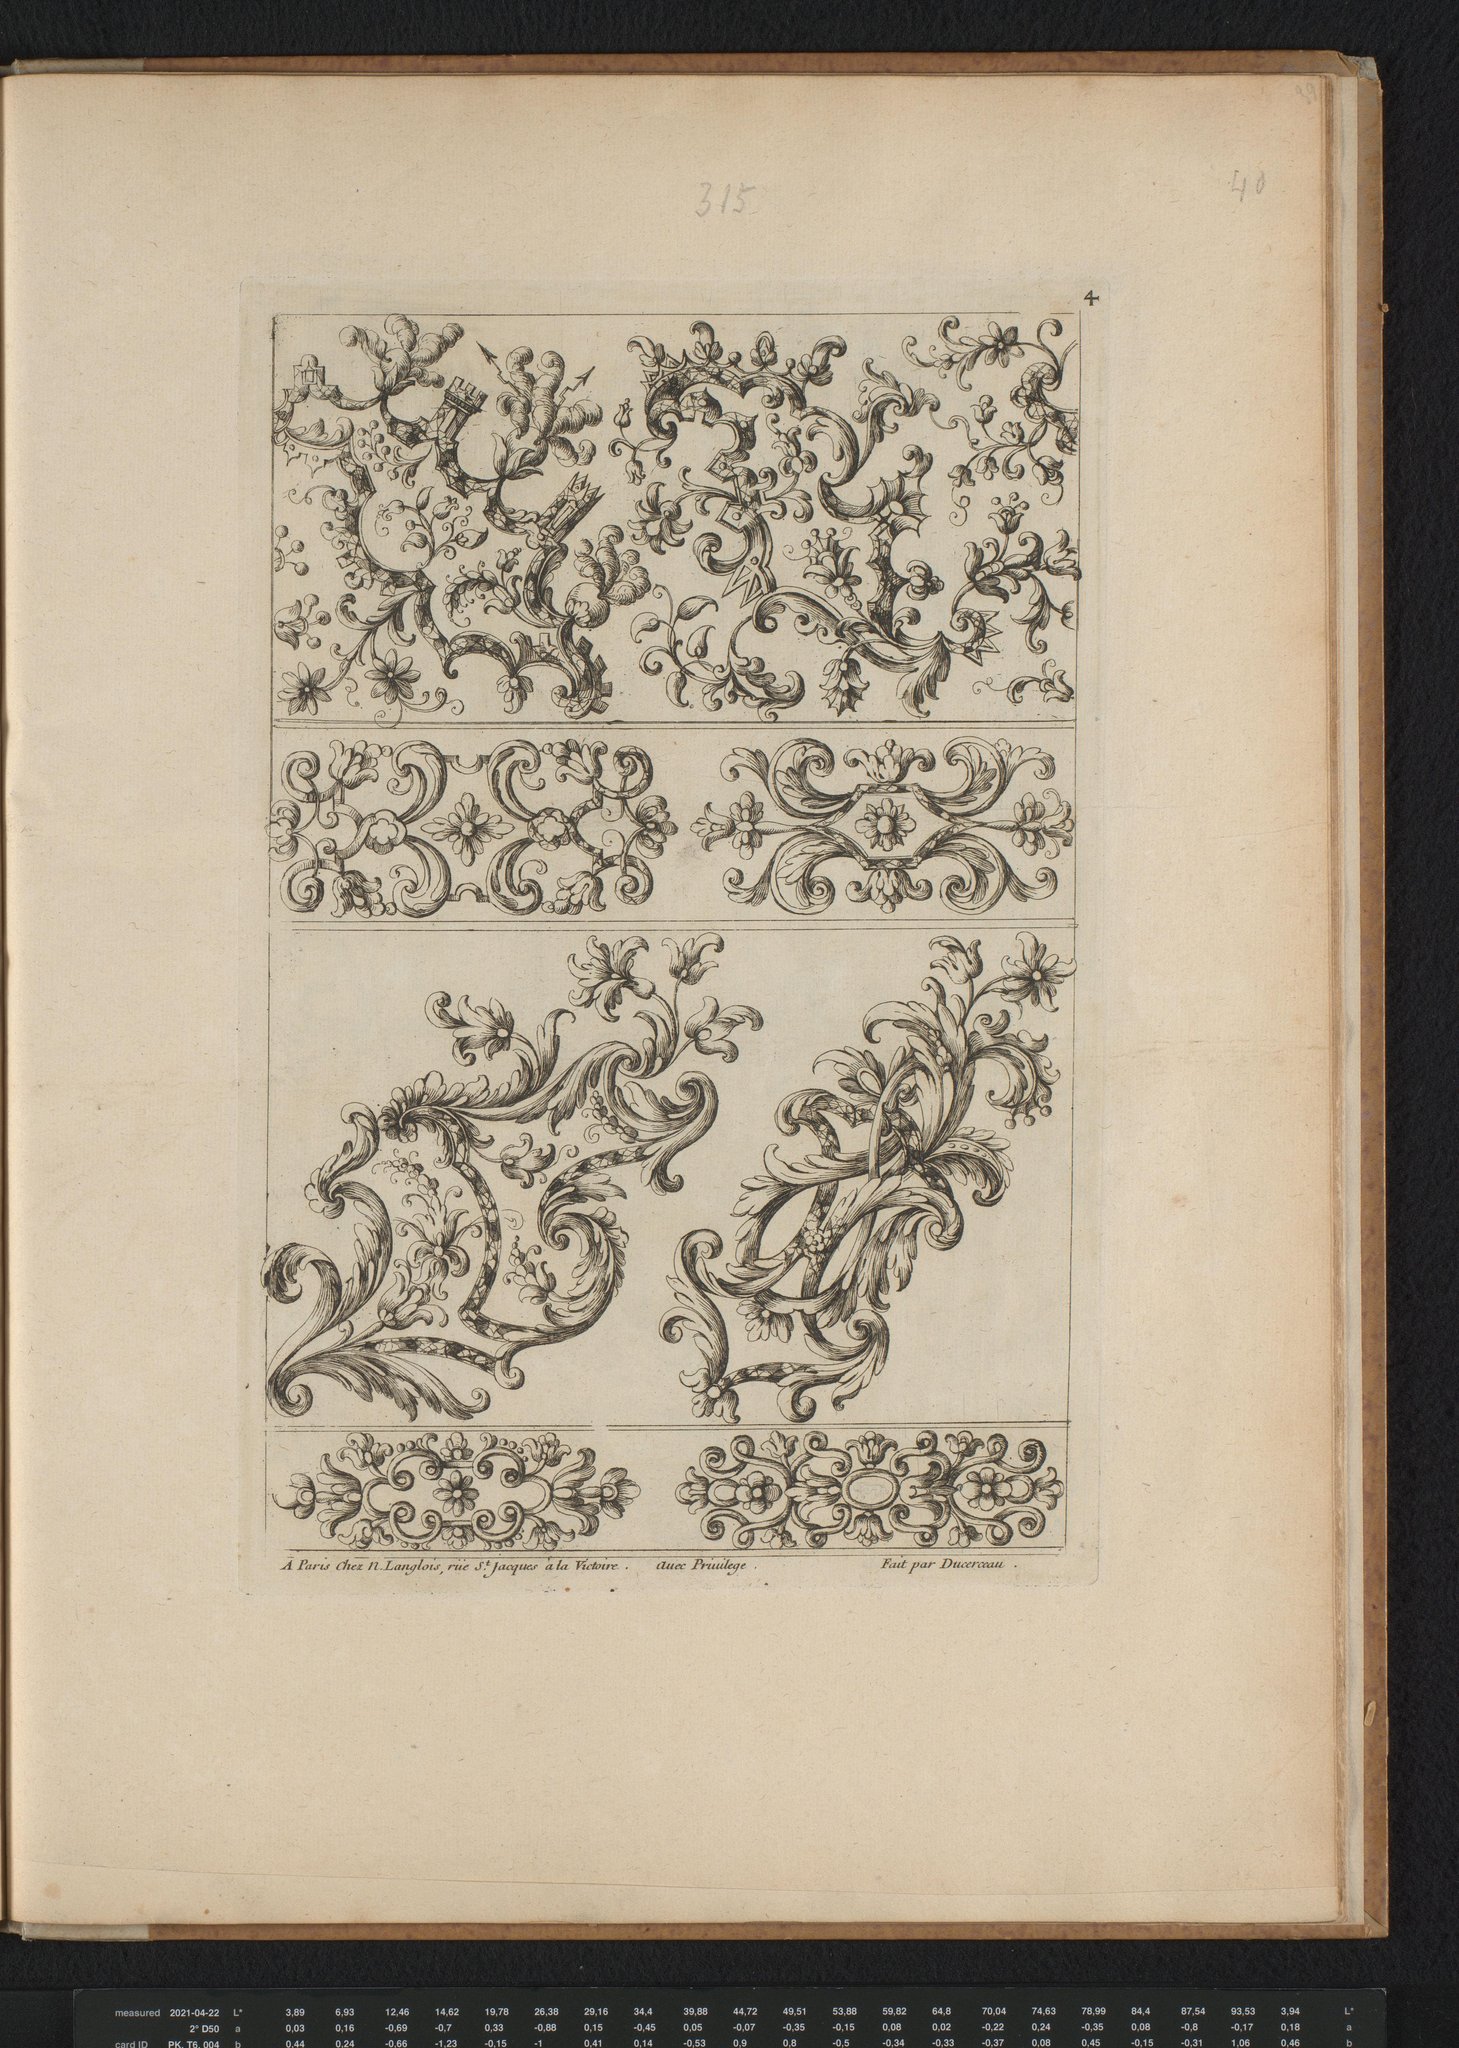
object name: ornament print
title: Vier banden met bladmotieven en marmeren inlegwerk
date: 1670-1690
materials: paper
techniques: etching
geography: paris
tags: foliage, tendrils, branches ~ ornament, embroidery (ornamentation)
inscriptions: collector's mark: Lugt 2228a, collector's mark: Lugt 2760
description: Deze prent maakt deel uit van een album.